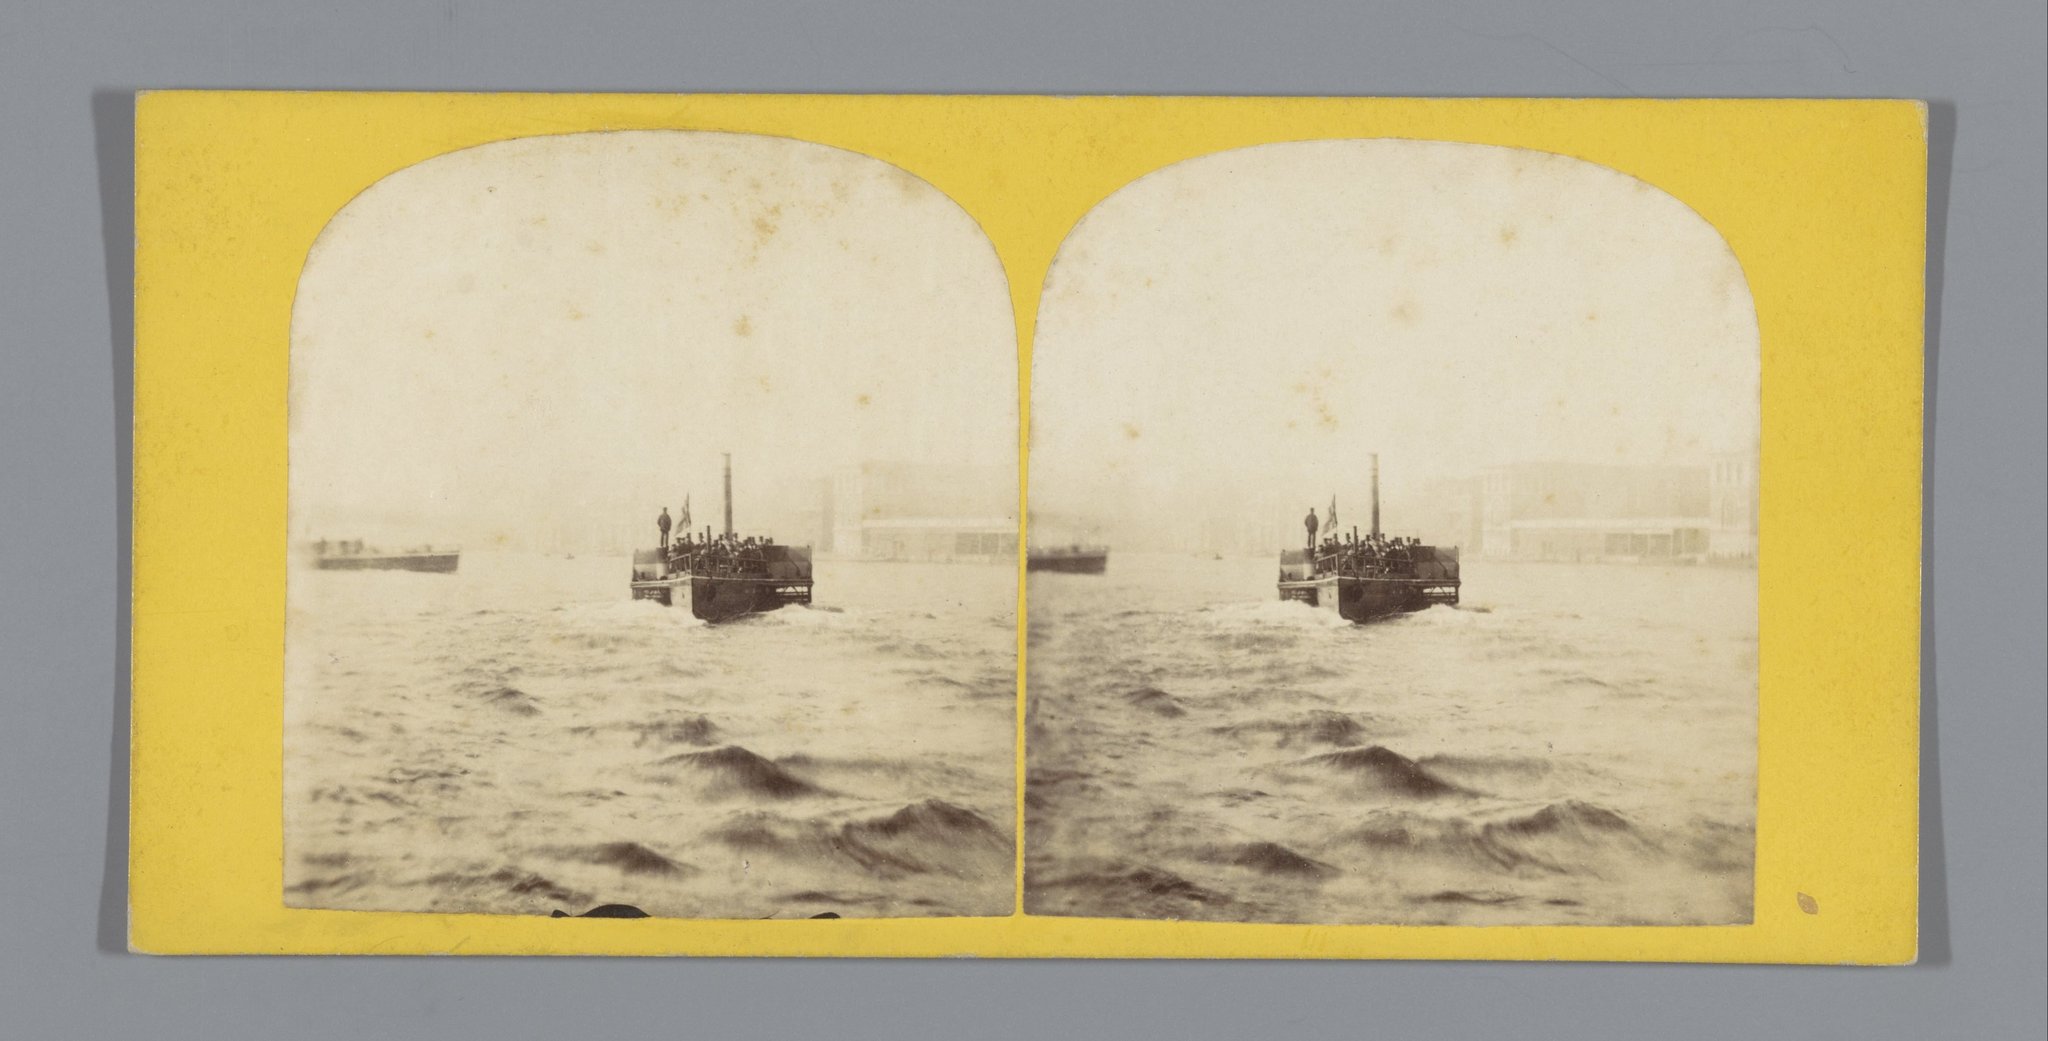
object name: stereograph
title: Thames Steam Boat. Taken from London Bridge Pier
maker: Anonymous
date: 1850-1880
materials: cardboard, photographic support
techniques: albumen print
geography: london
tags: steamsailer, river, thames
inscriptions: inscription: ‘Instantaneous’, number: ‘119’, number: ‘113. No.2.’